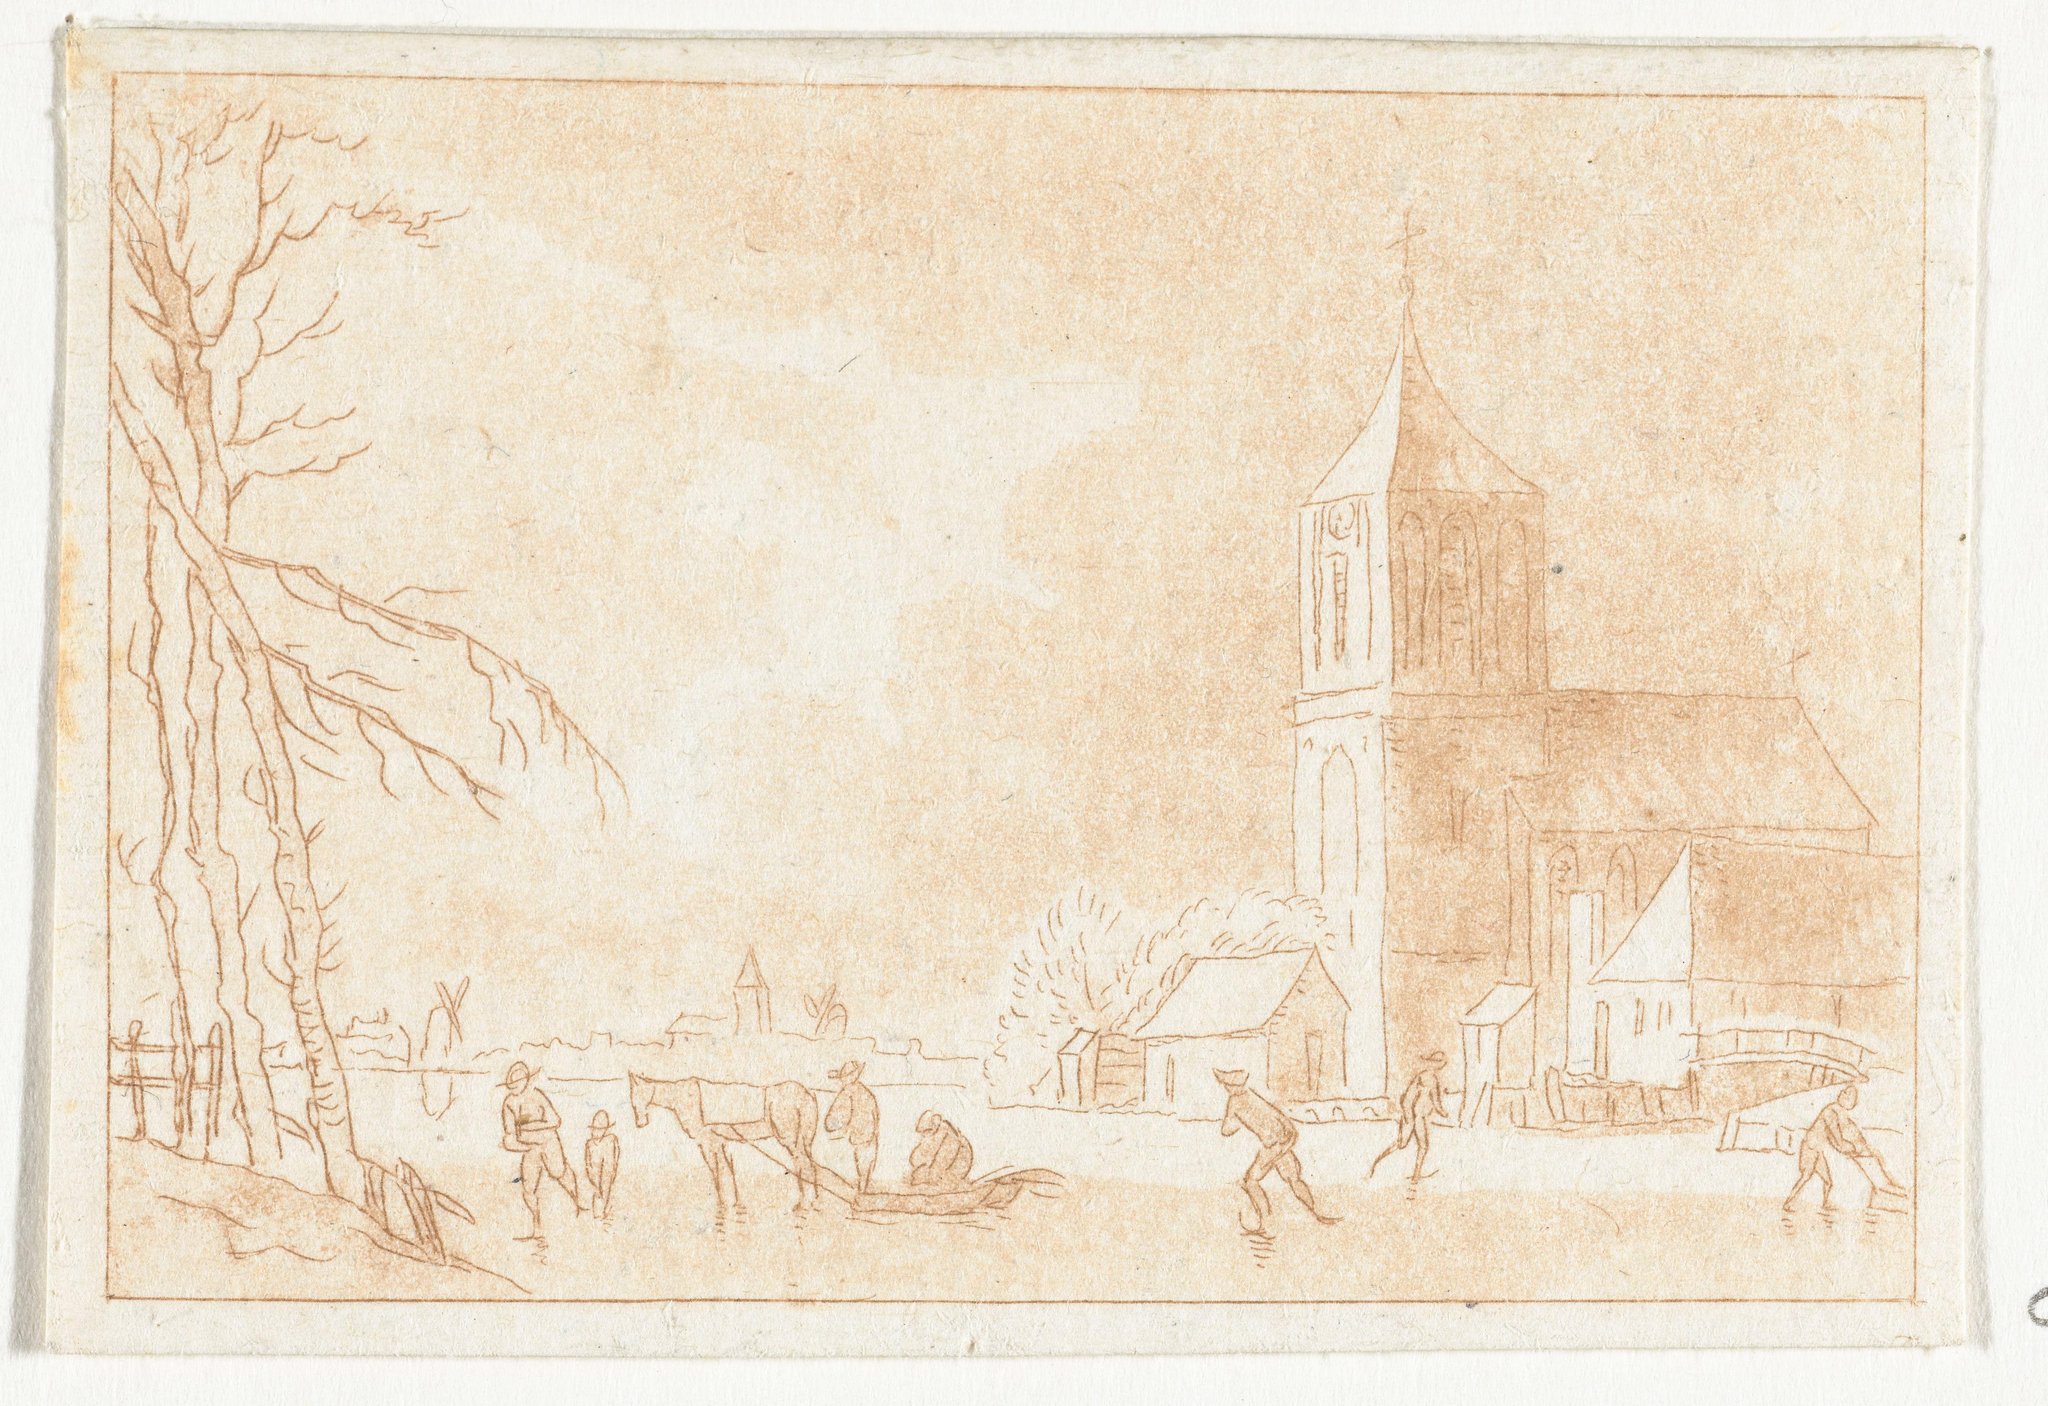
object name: print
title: Wintergezicht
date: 1778-1838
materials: paper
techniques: printmaking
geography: netherlands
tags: ice ~ freezing weather, skates (winter sports) (+ out of doors (sports, games, etc.))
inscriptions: collector's mark: Lugt 2228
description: Schaatsers op het ijs, op de achtergrond een kerk met huizen.